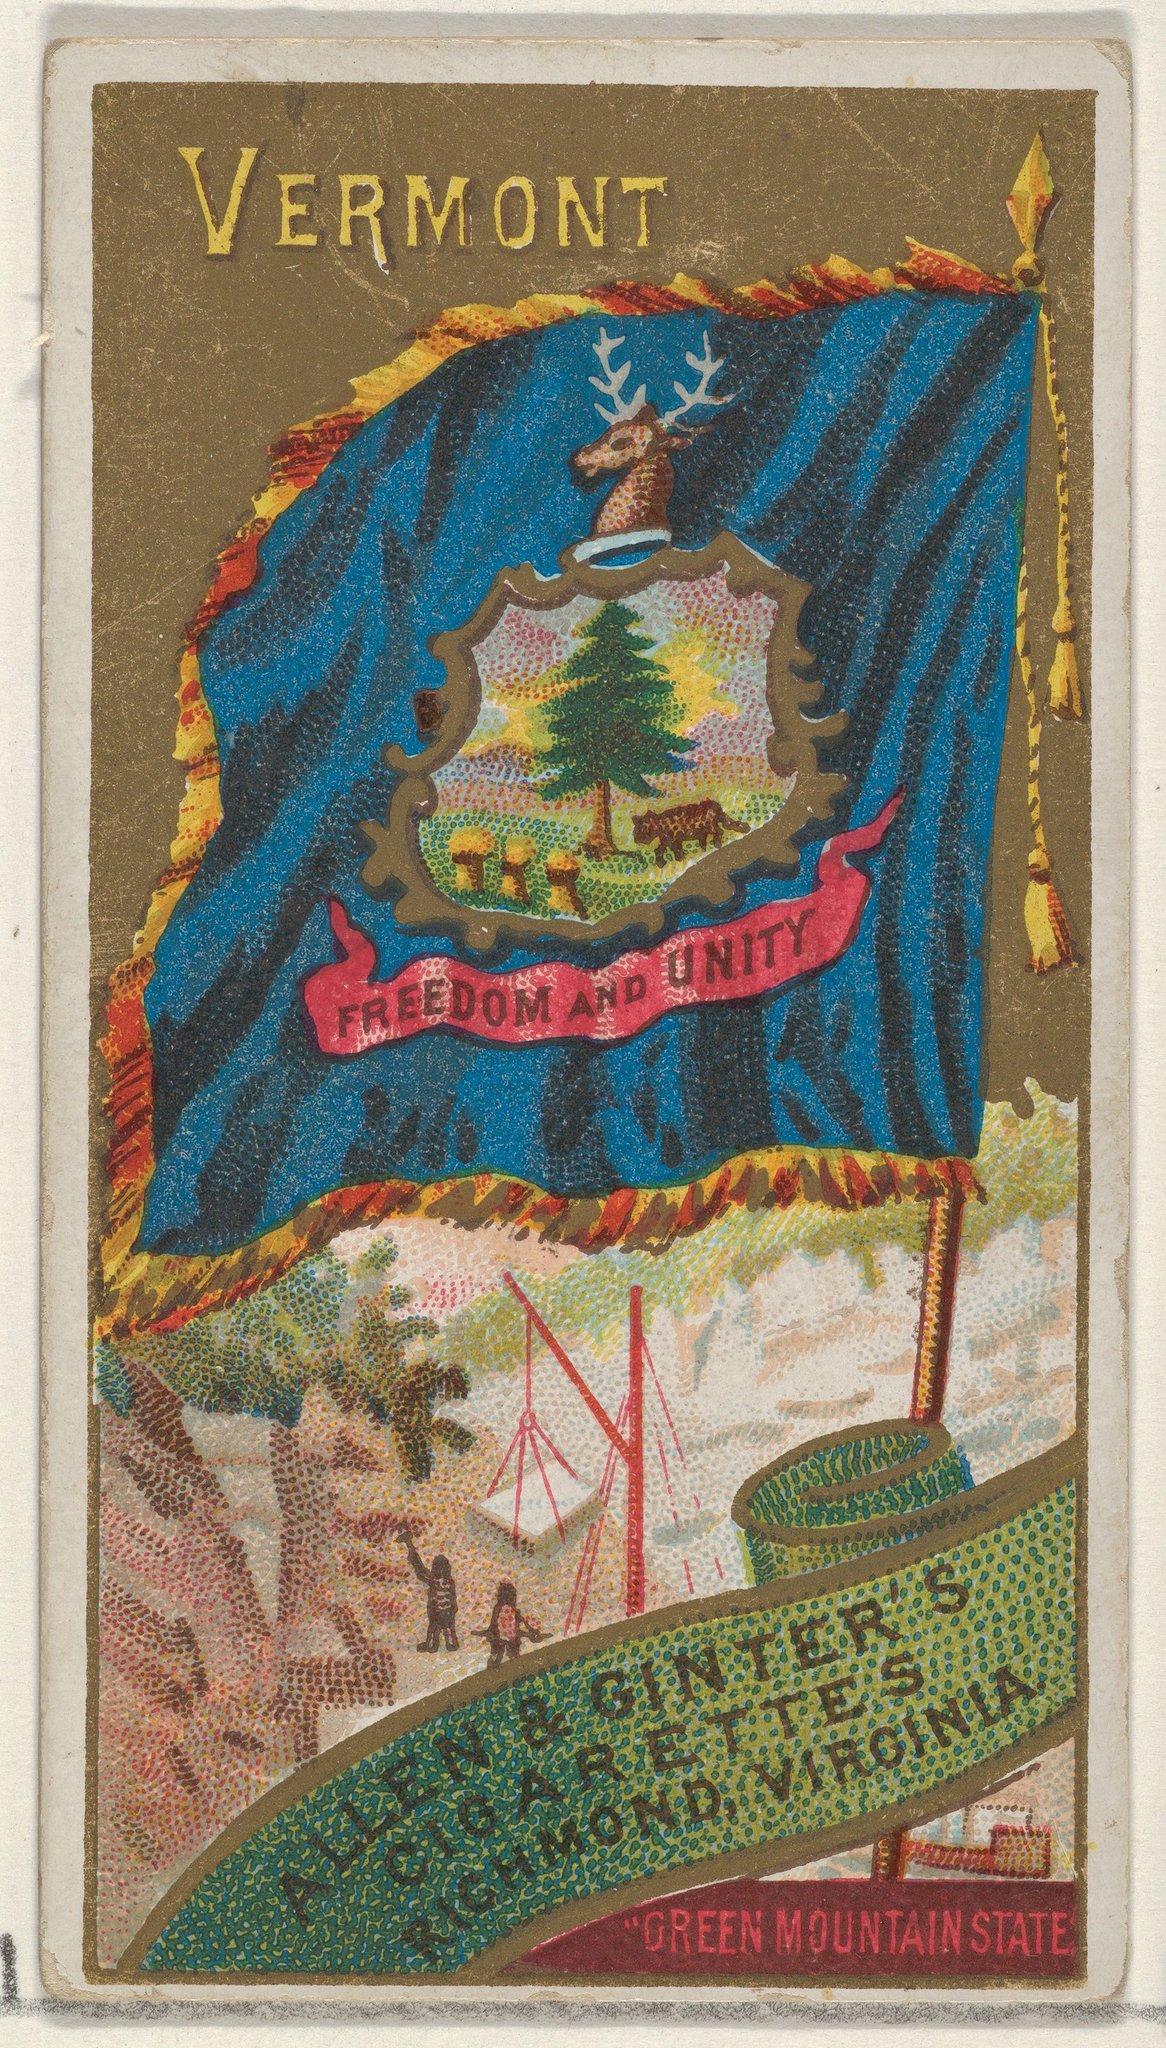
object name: print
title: Vermont, from Flags of the States and Territories (N11) for Allen & Ginter Cigarettes Brands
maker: allen & ginter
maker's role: publisher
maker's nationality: american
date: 1888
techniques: color lithograph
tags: flags